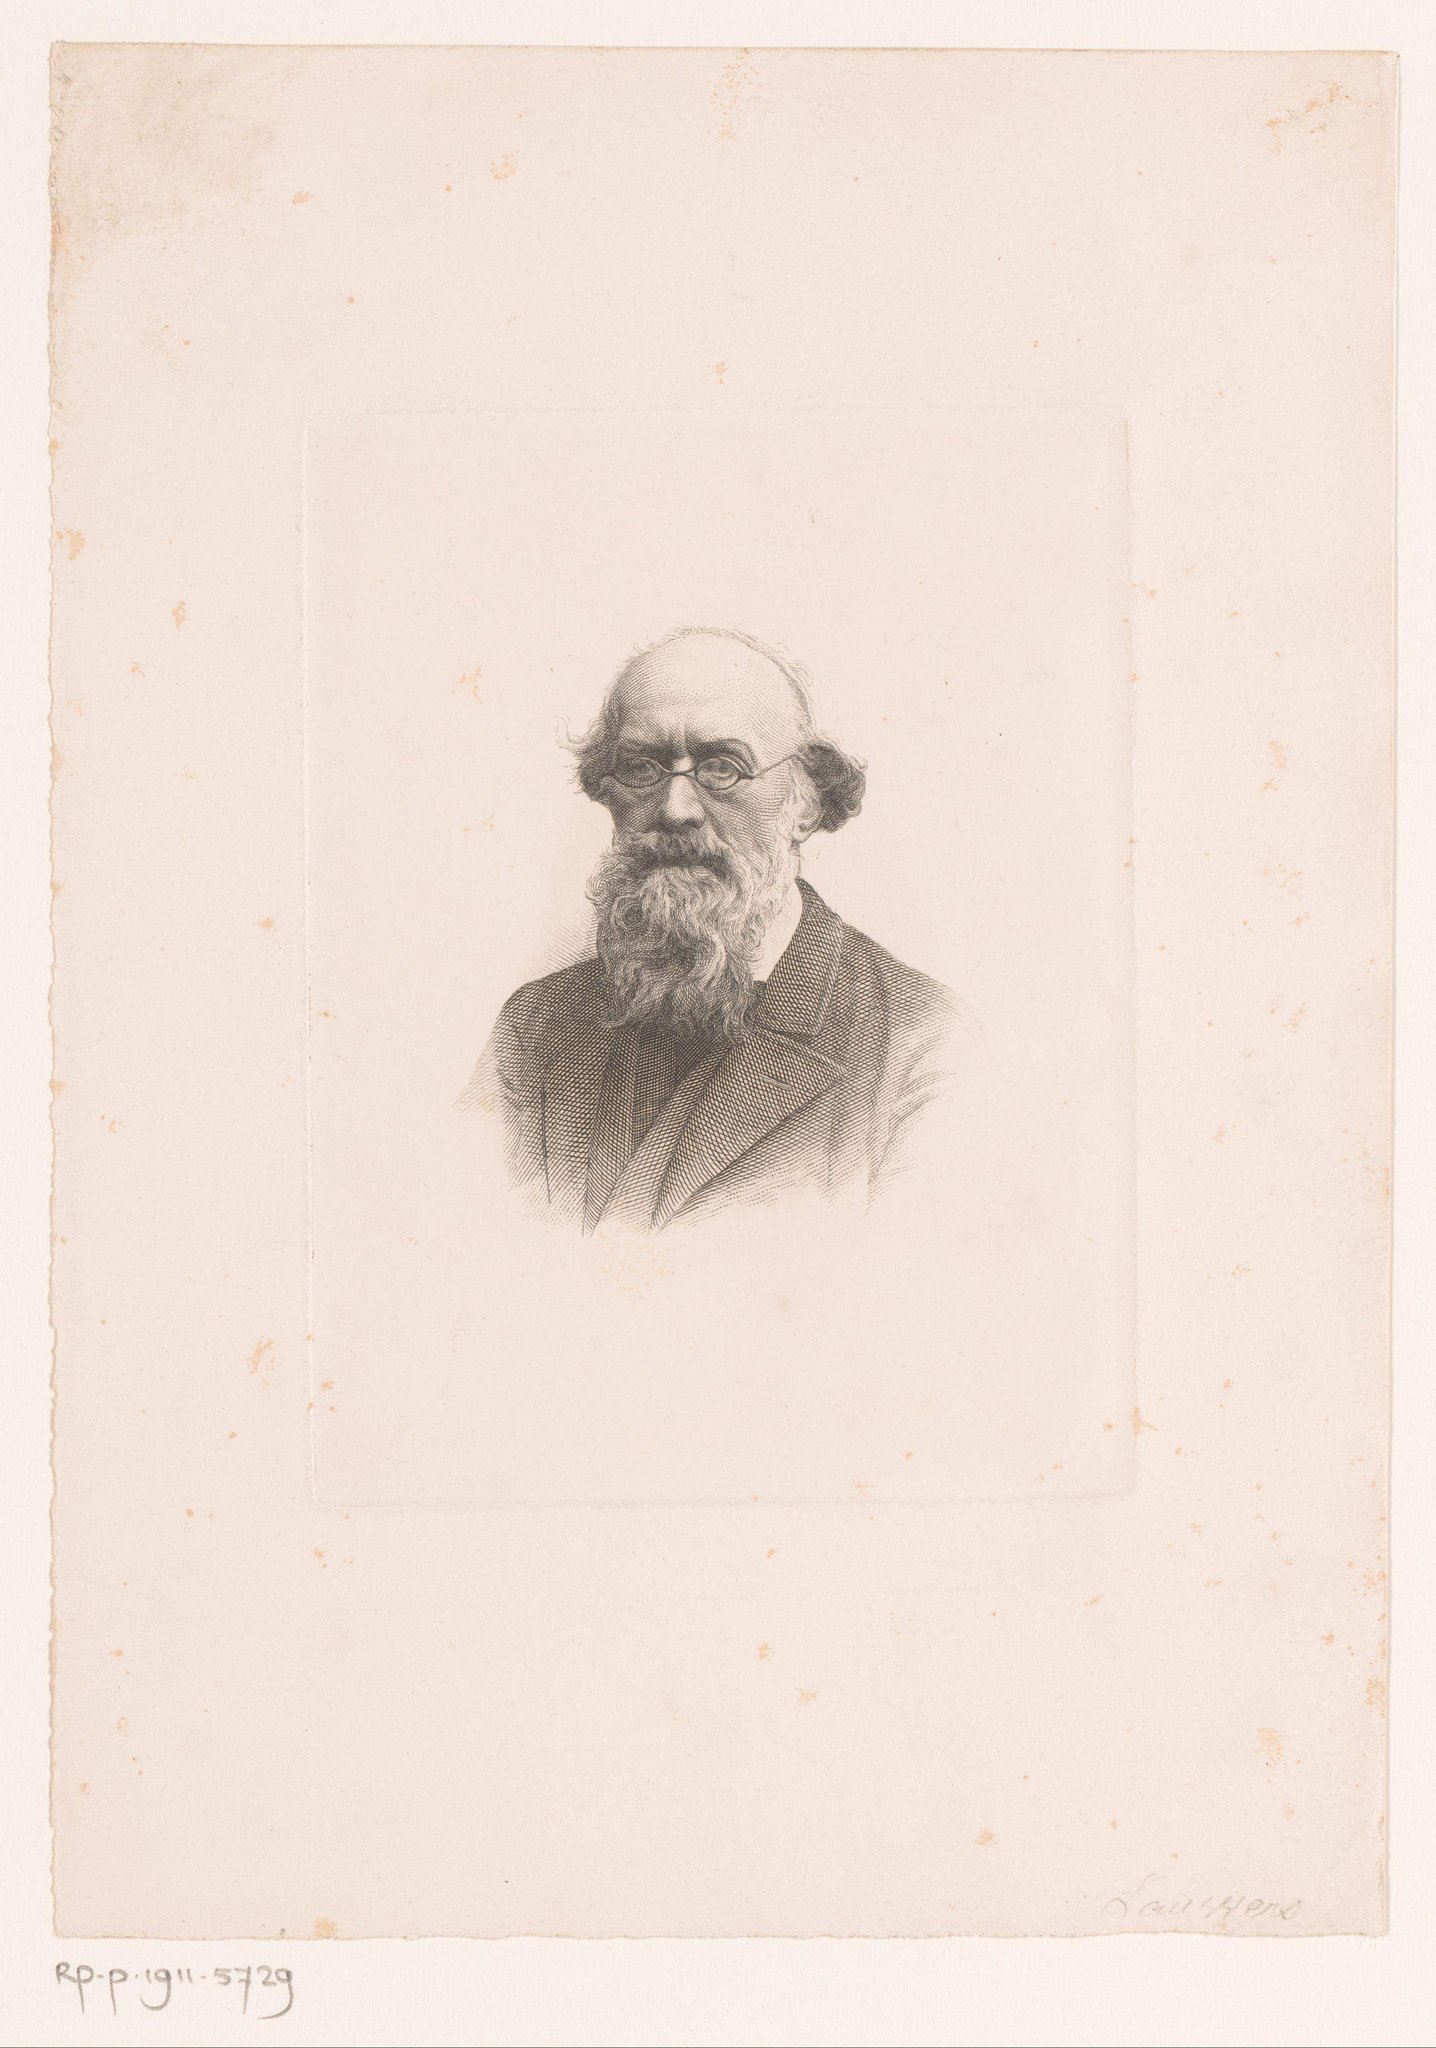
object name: print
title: Portret van een onbekende man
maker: frans lauwers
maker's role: print maker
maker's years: 1854-1931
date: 1864-1911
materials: paper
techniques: etching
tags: eyeglasses, spectacles, anonymous historical person portrayed alone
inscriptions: collector's mark: Lugt 2228